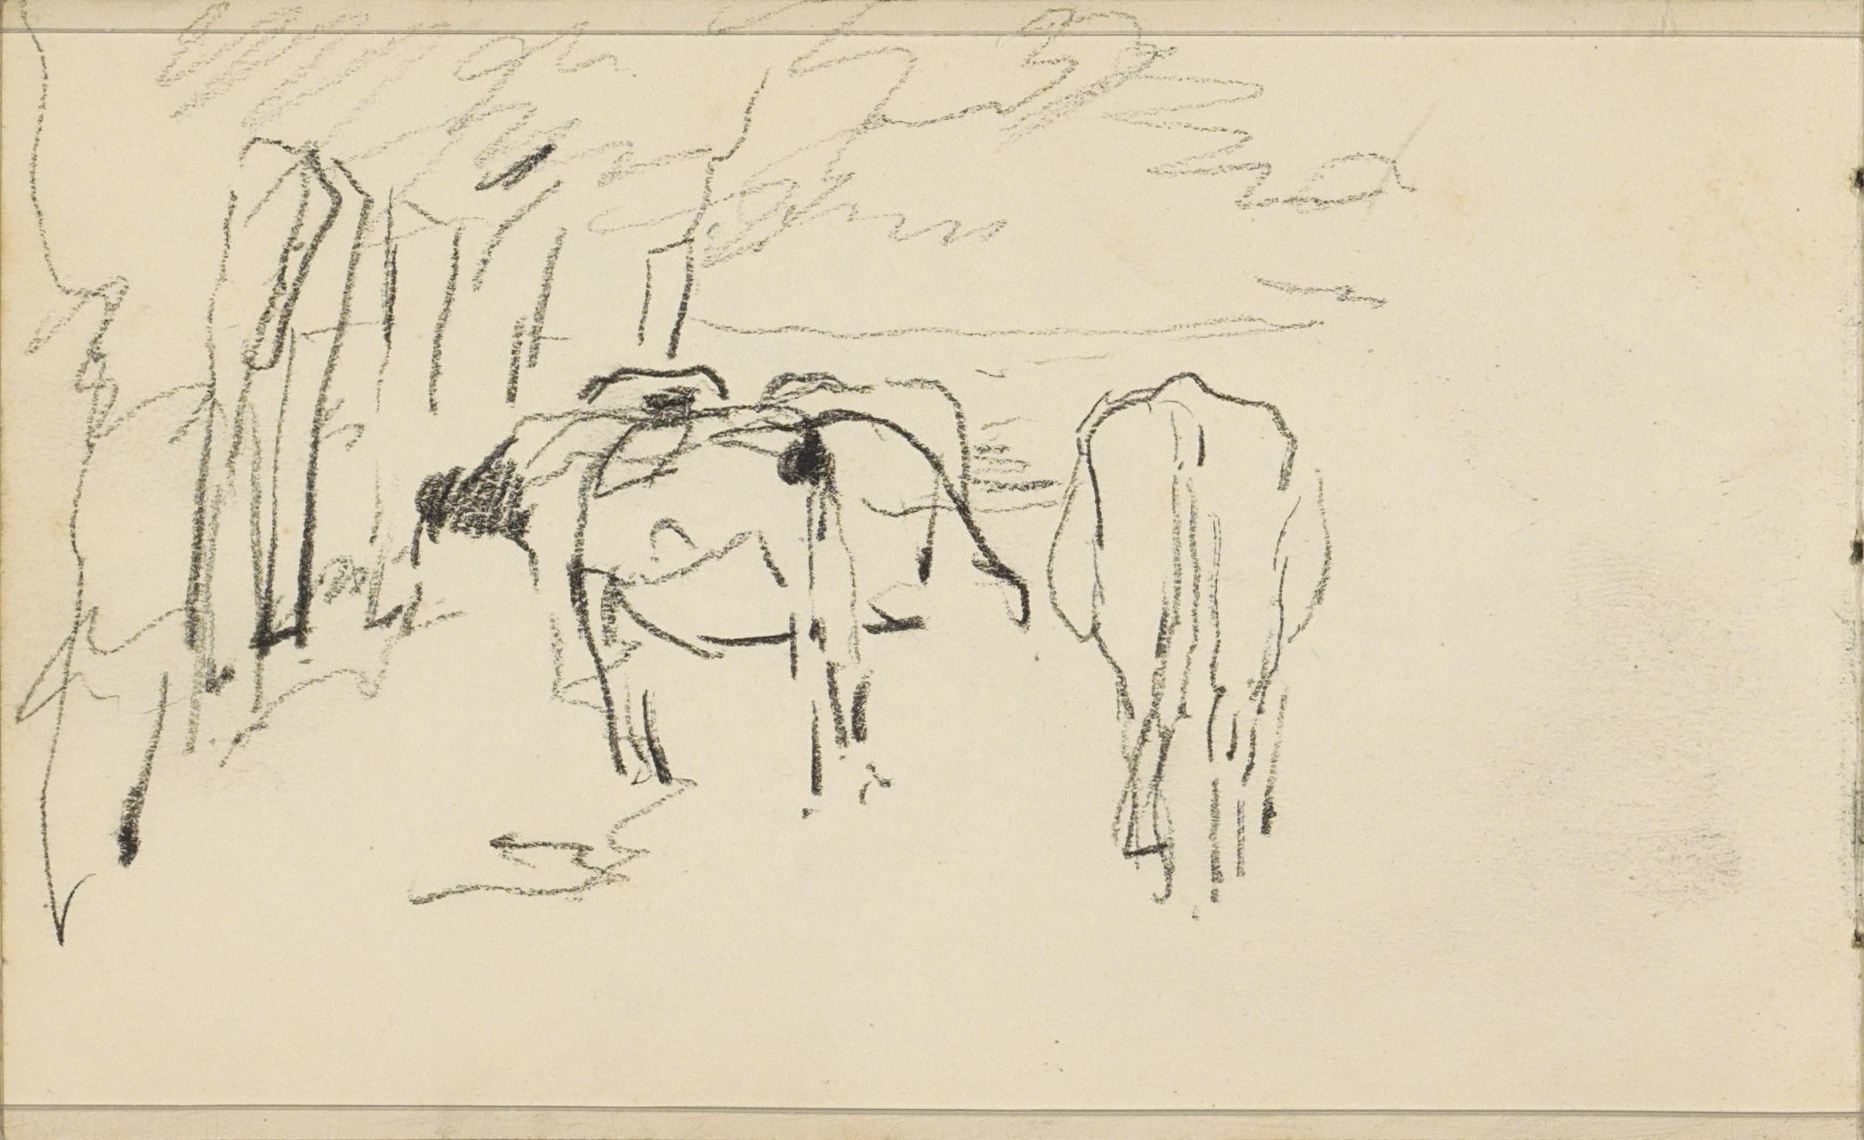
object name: sketchbook leaf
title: Koeien naast een rij bomen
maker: anton mauve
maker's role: draughtsman, painter, print maker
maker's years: 1838-1888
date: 1876-1888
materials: chalk, paper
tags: cow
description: Blad 13 verso uit een schetsboek met 34 bladen.